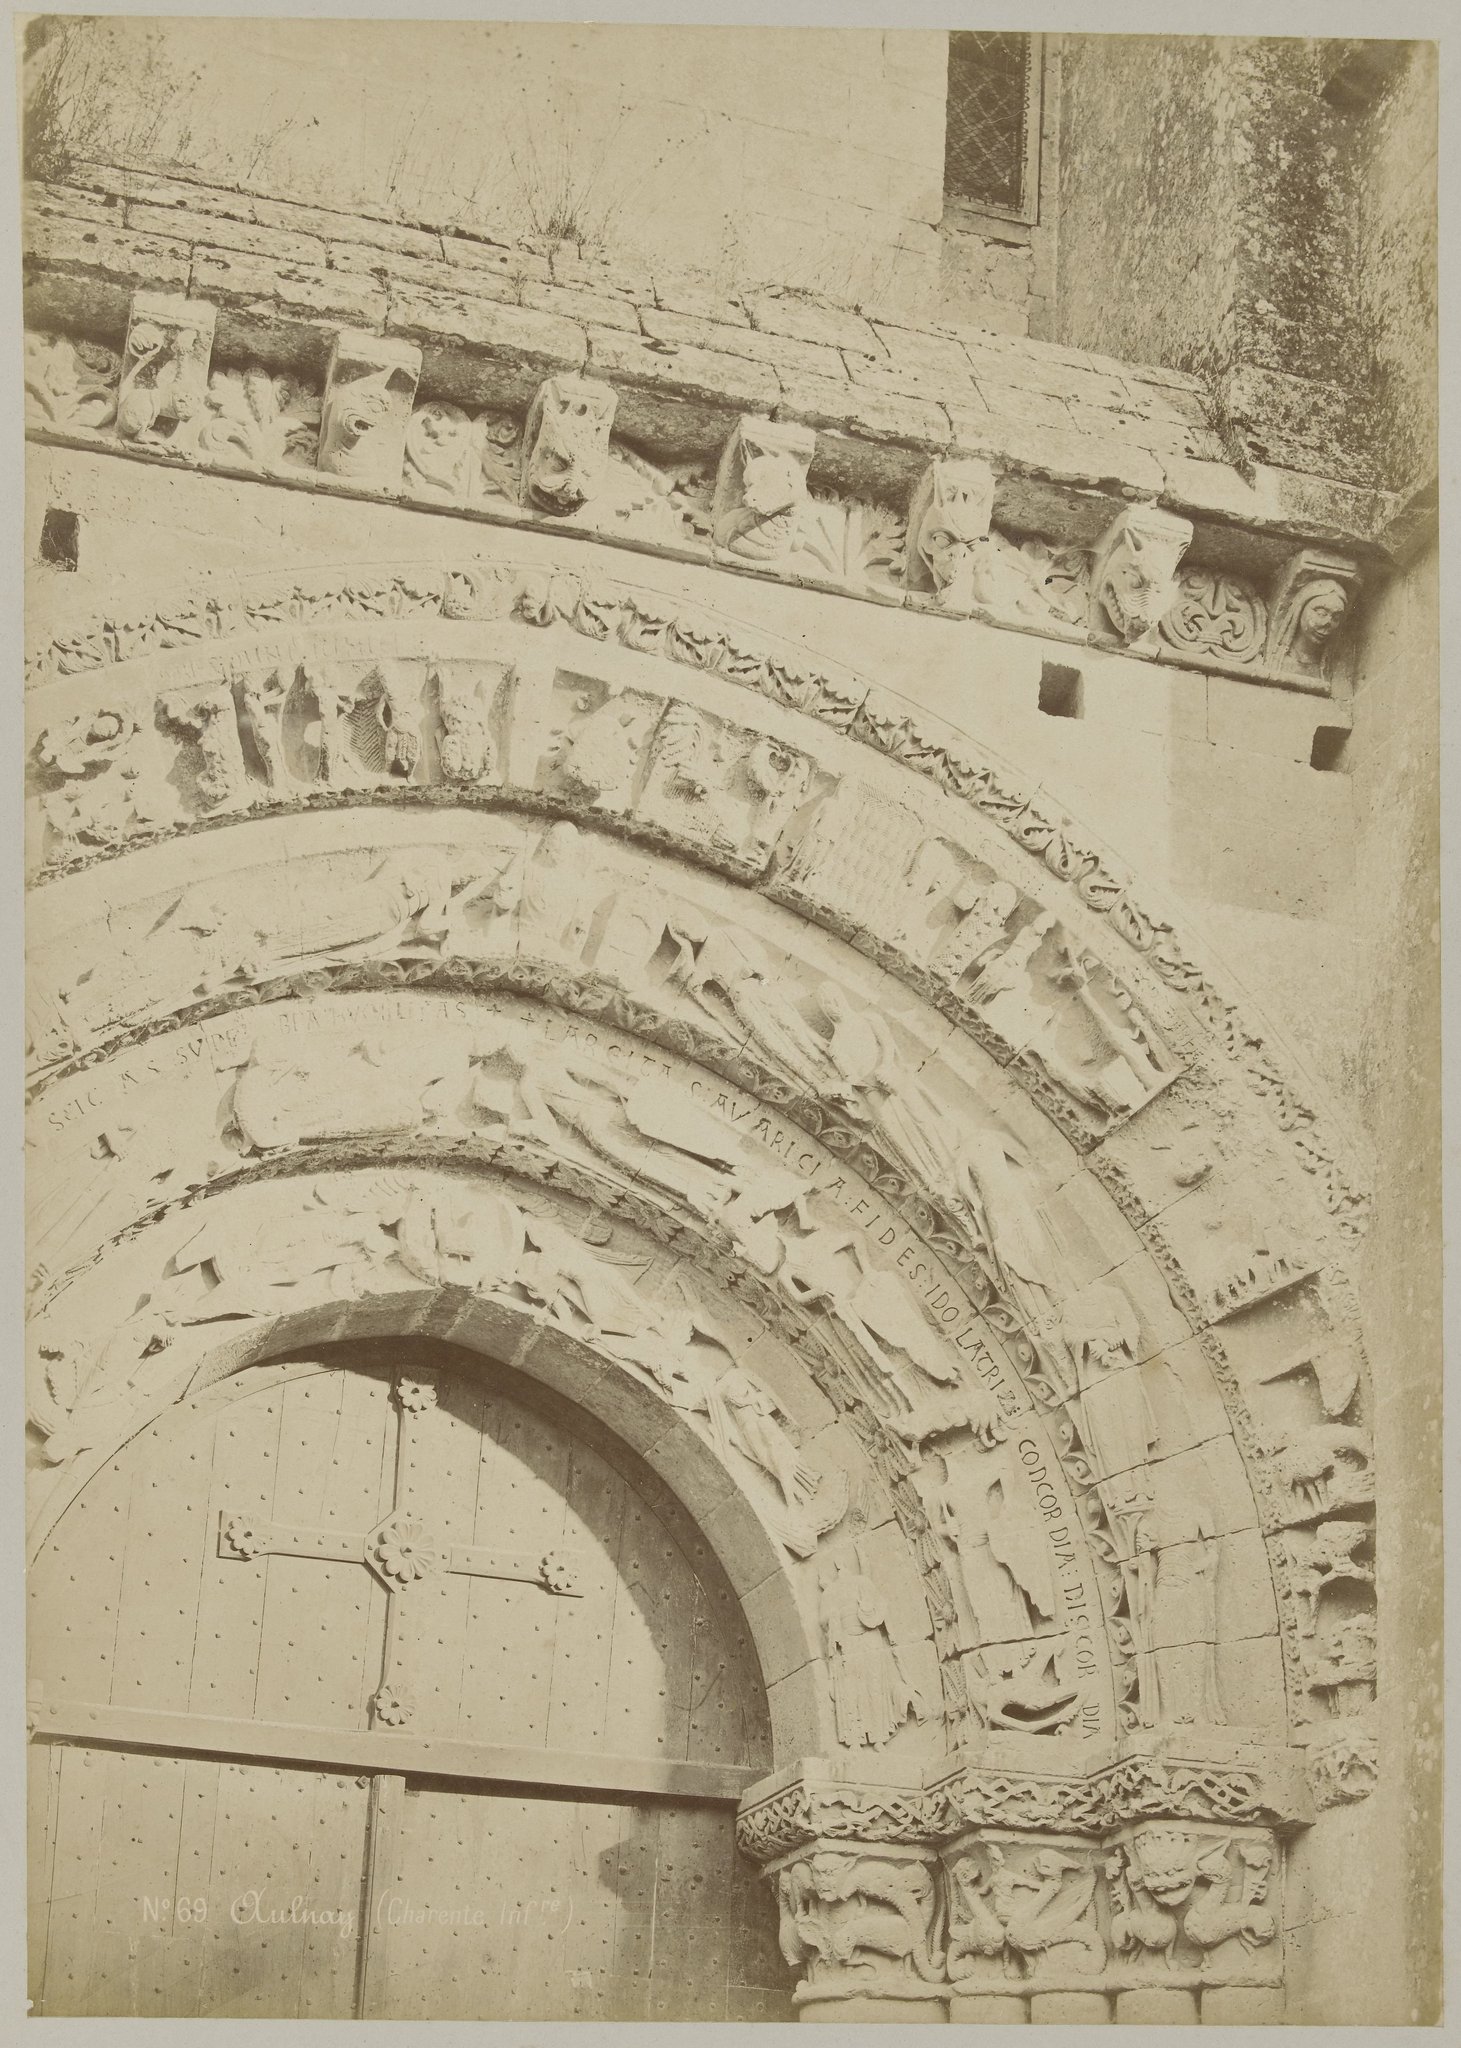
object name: photograph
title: Beeldhouwwerken boven een portaal van de kerk van Saint-Pierre d'Aulnay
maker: paul robert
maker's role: fotograaf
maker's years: 1865-1905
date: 1890-1900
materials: cardboard, paper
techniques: albumen print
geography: aulnay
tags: parts of church exterior and annexes: portal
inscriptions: number: ‘No. 69’